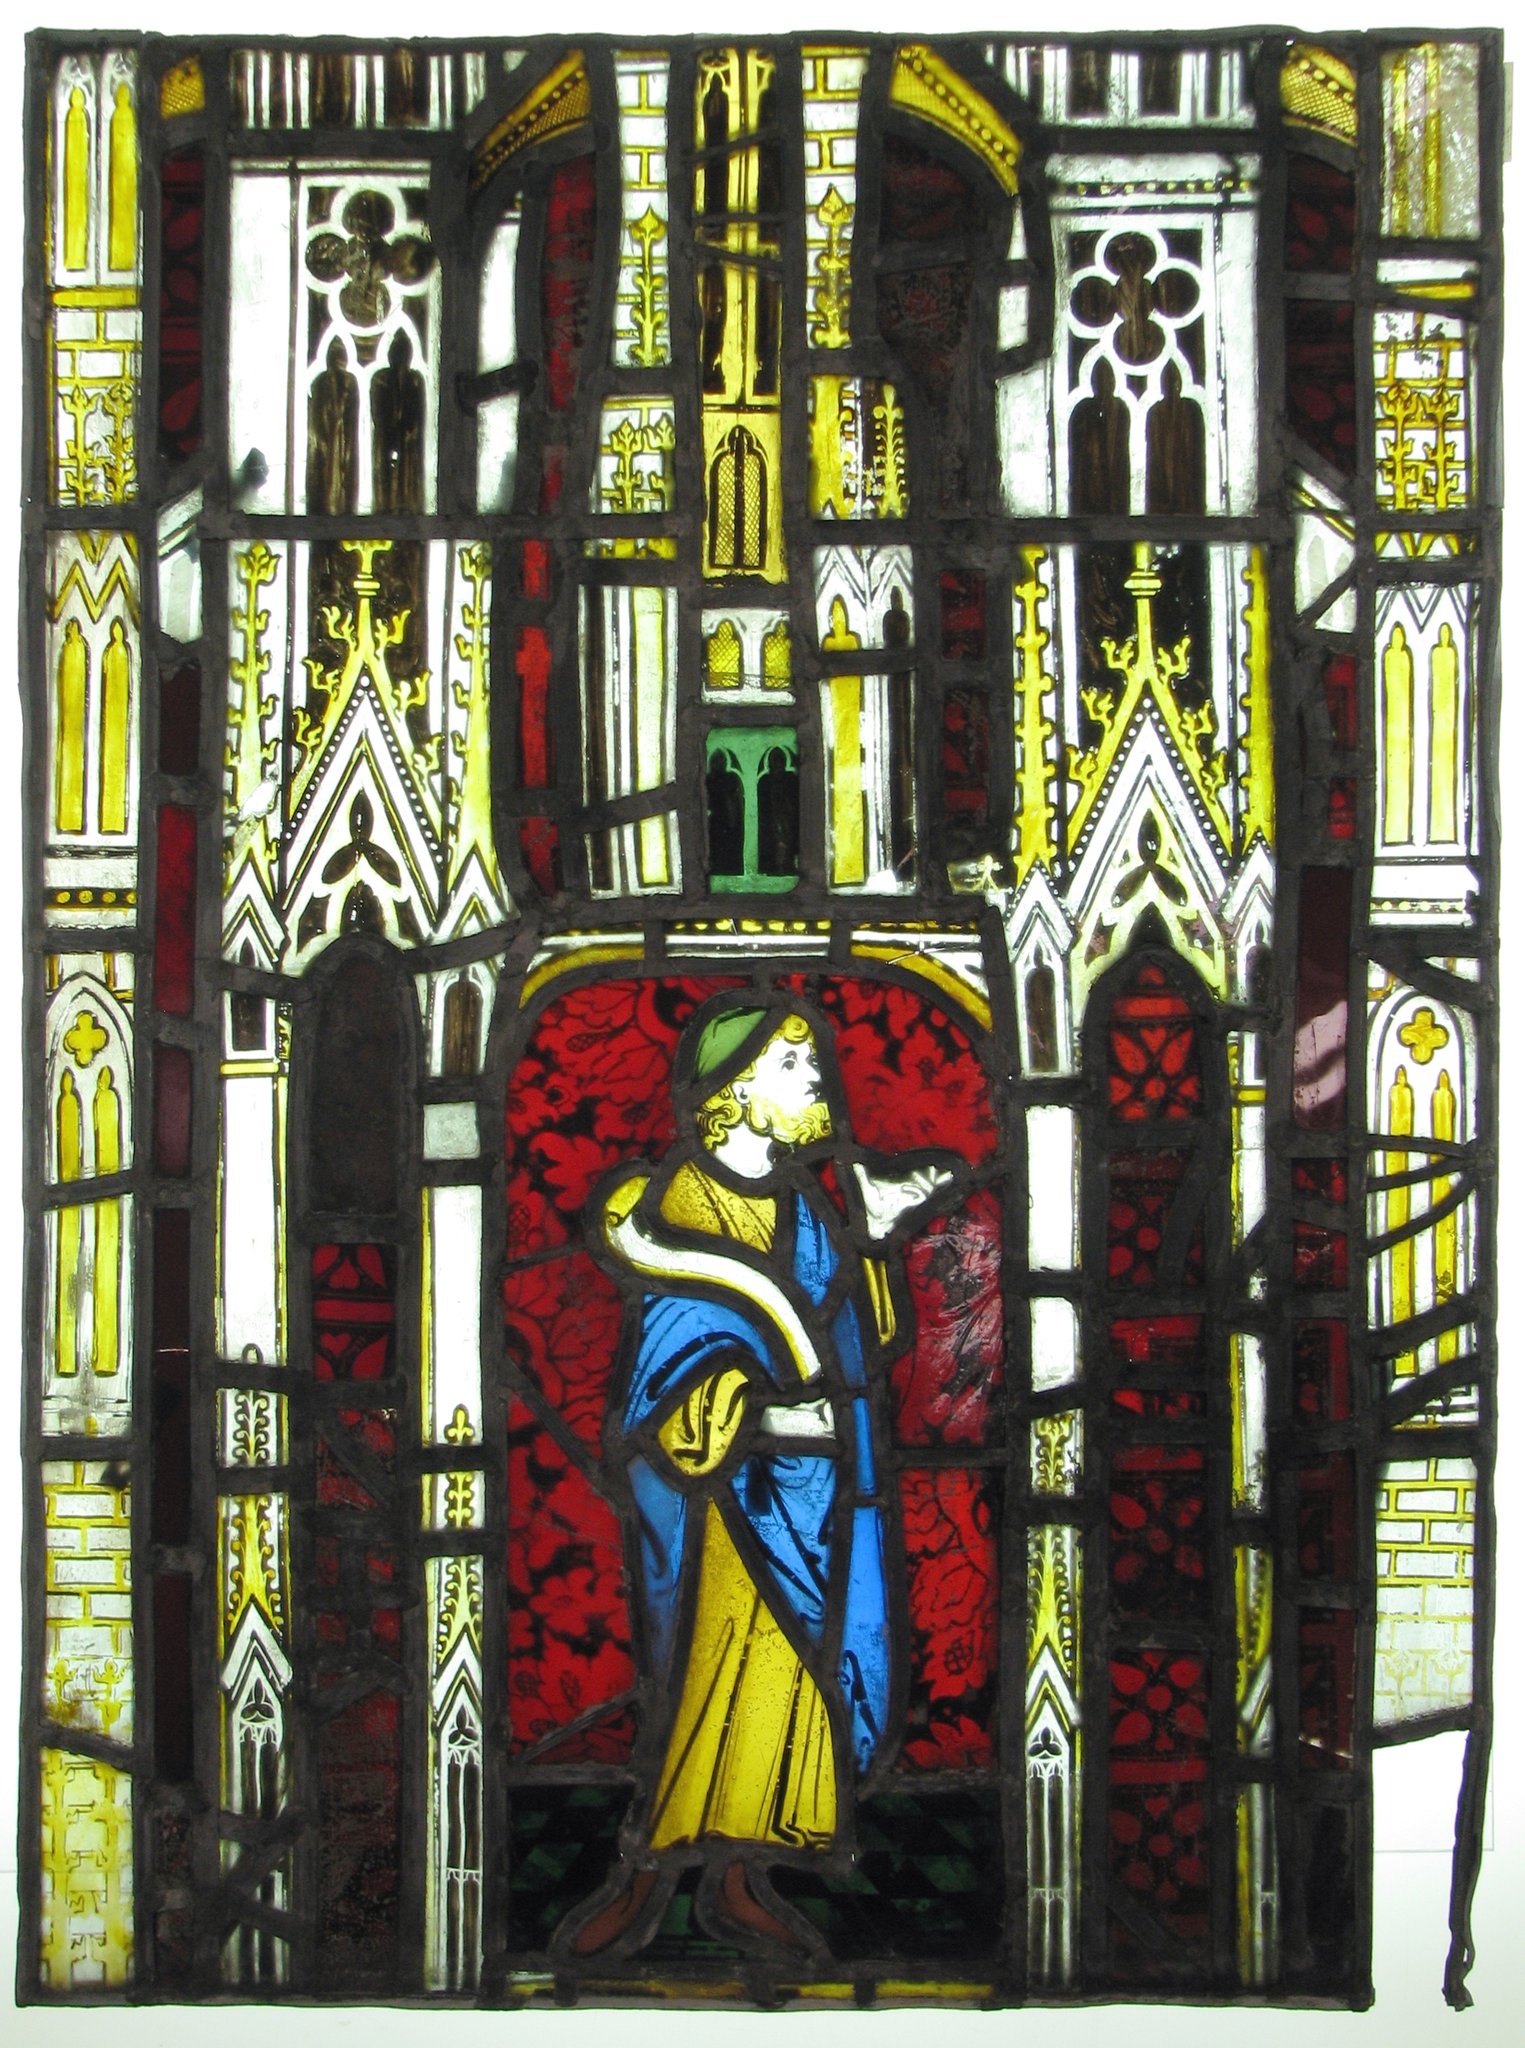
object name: panel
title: Panel with Standing Figure under Architectural Detail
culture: french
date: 1301-1400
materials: glass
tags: men